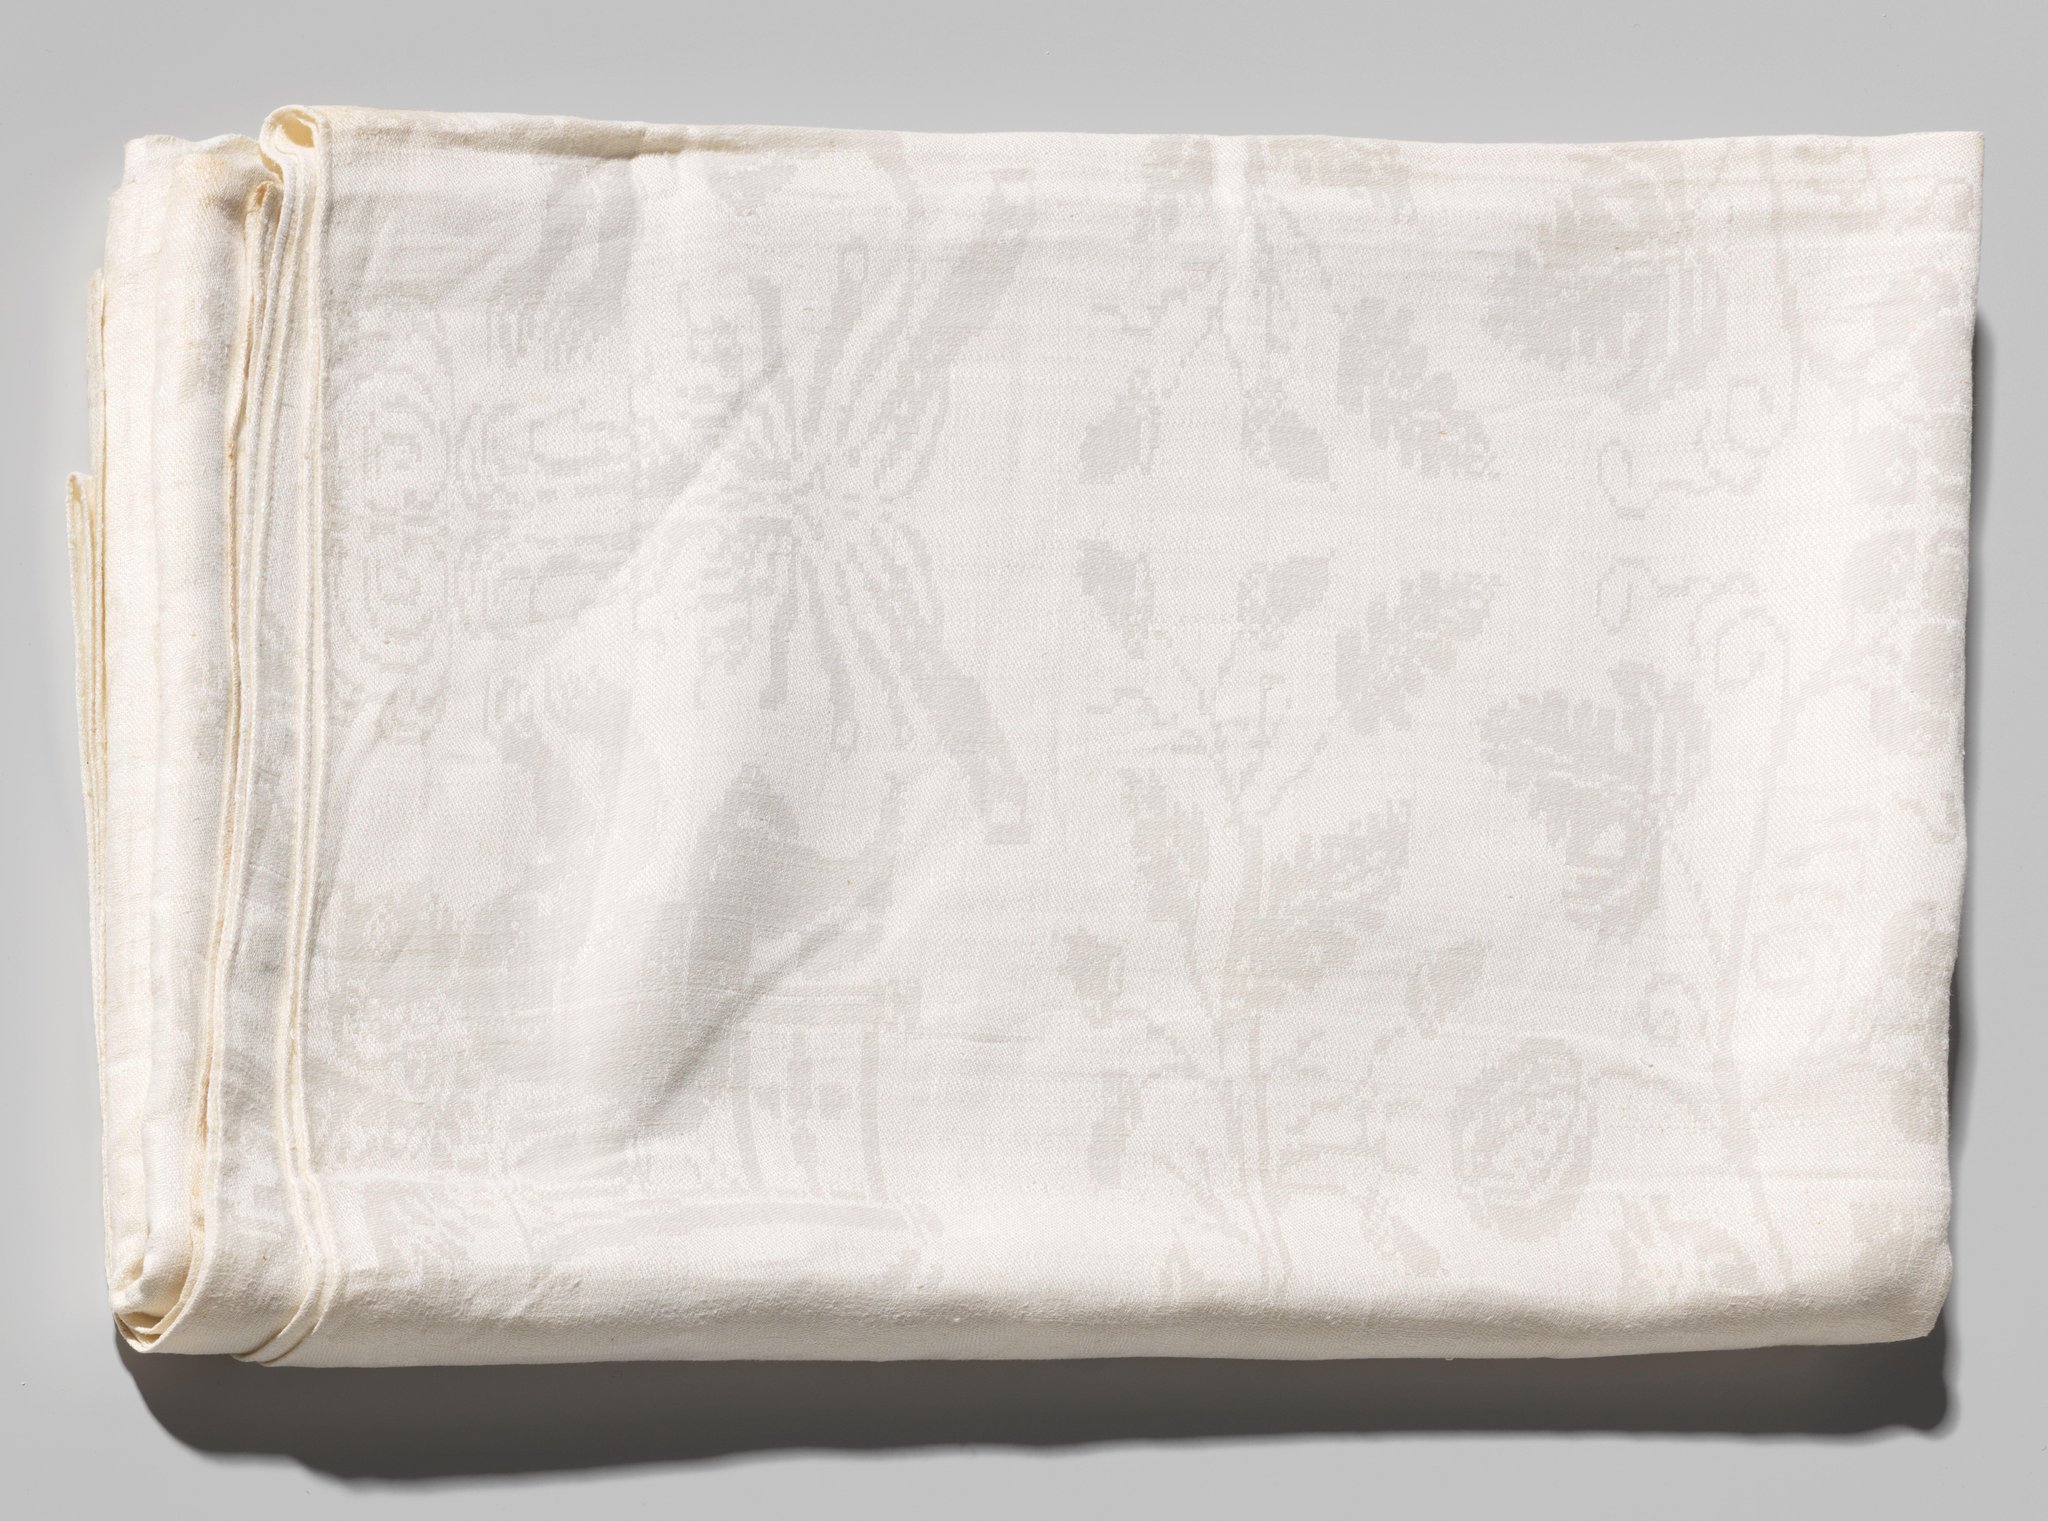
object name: tablecloth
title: Tafellaken met personificaties van de vier seizoenen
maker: Anonymous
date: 1650-1699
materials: linen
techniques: damask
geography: low countries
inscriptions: mark: ‘H.B.’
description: Tafellaken van linnendamast de vier seizoenen. Het in de breedte driemaal herhaalde patroon vertoont vier taferelen. Binnen ovalen staan putti, emblemen houdende van het betreffende seizoen. 1 De lente. Twee toegewende gevleugelde putti met een lage mand met bloemen worden omlijst door onder andere narcissen, hyacinthen en tulpen. Deze liggend ovale omlijsting wordt in elk tafereel gevormd door bloemtakken, die links en rechts voortspruiten uit akanthus-arabesken. Deze zijn naar boven en beneden gericht en verbonden door een stam. Hier zijn deze stammen getorst en met de aansluitende ovalen verbonden door een rolwerkcartel. 2 De zomer. Het ovaal is van vruchtentakken en korenaren. De putti zijn afgewend en dragen een bundel korenaren en een sikkel. De stam tussen de akanthussen is balustervormig. 3 De herfst. Omlijsting van wijnranken met druiventrossen, meloenen en granaatappels. Toegewende putti dragen samen een druiventros en in de buitenste hand ieder een wijnglas. De verbindingsstammen zijn geschubd en door een ring verbonden. 4 De winter. Toegewende putti zijn gezeten op stoelen en zij verwarmen zich de handen aan een blokkenvuur. Omlijsting van hulst- en eikentakken. De stammen zijn meermalen geringd. Staande randen: op een middenstengel staan bloemen, waaronder een sterrozet, narcis, anjer, eikel, tulp. Vertakkingen symmetrisch en met dergelijke bloemen.